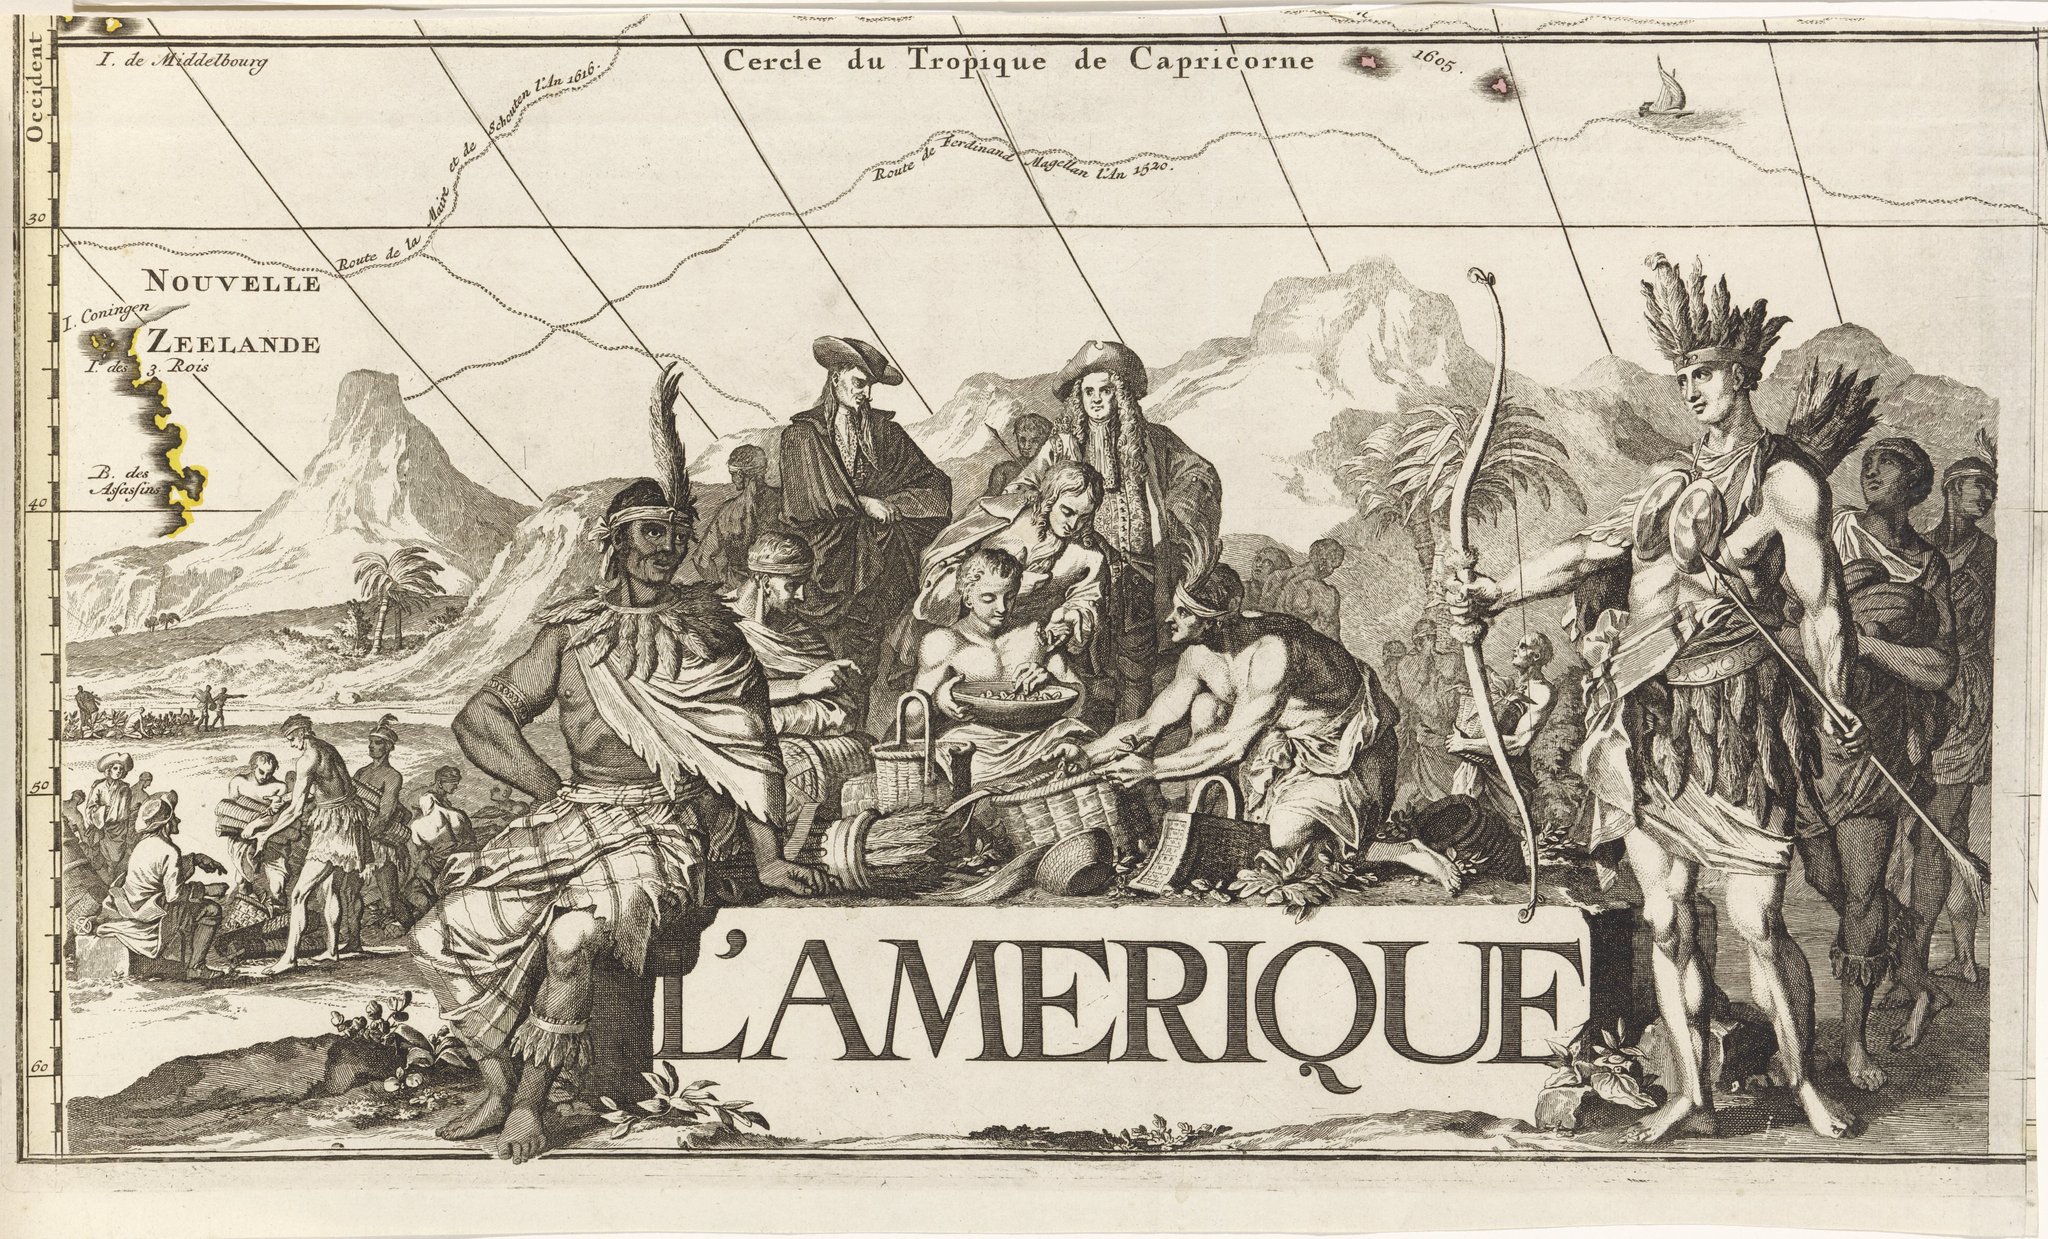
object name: print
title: De Vier Werelddelen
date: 1720-1772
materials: paper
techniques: etching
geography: amsterdam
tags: trading expedition, archer's weapons: bow and arrow, (high) hill, native peoples of the americas, (map of) america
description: Vignet voor een kaart van Amerika, met Indianen waarvan er een met een pijl en boog. Op de achtergrond worden op twee plekken diverse producten aan Europese mannen getoond.